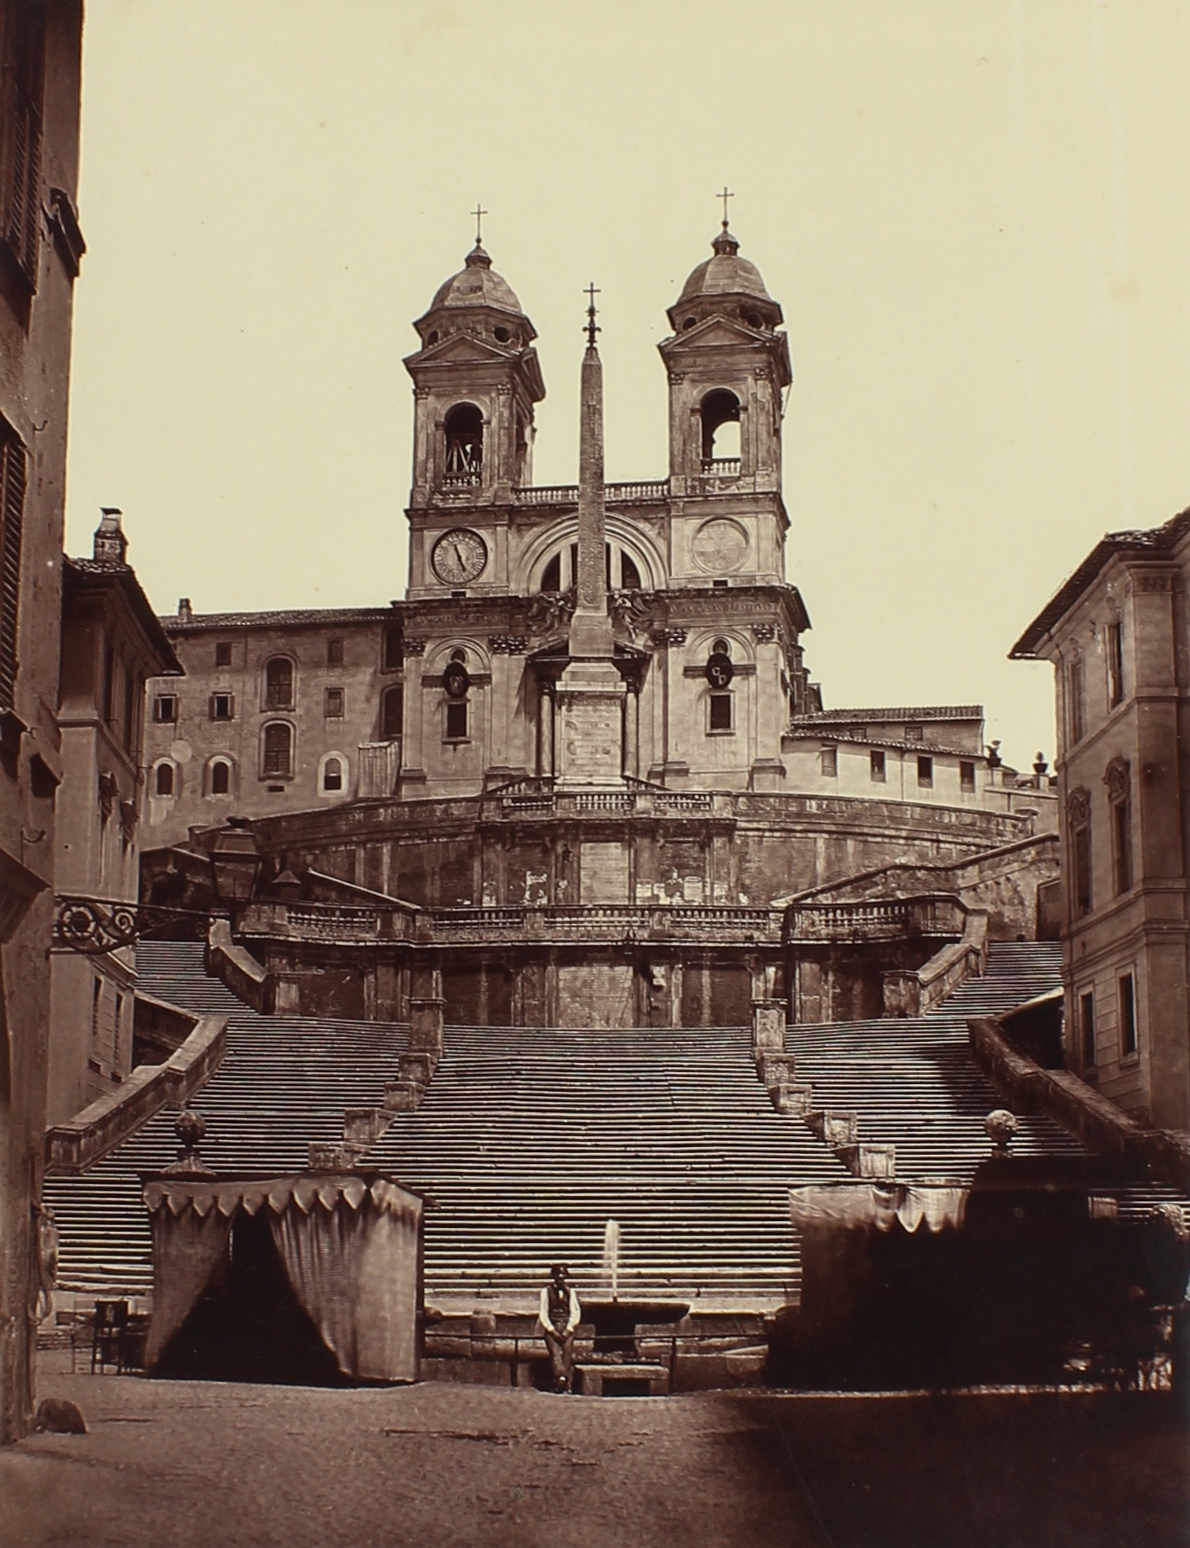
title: [Spanish Steps, Rome]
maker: pietro dovizielli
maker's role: artist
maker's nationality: italian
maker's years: 1804-1885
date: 1855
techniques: albumen silver print, glass negative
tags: architecture,stairs,churches